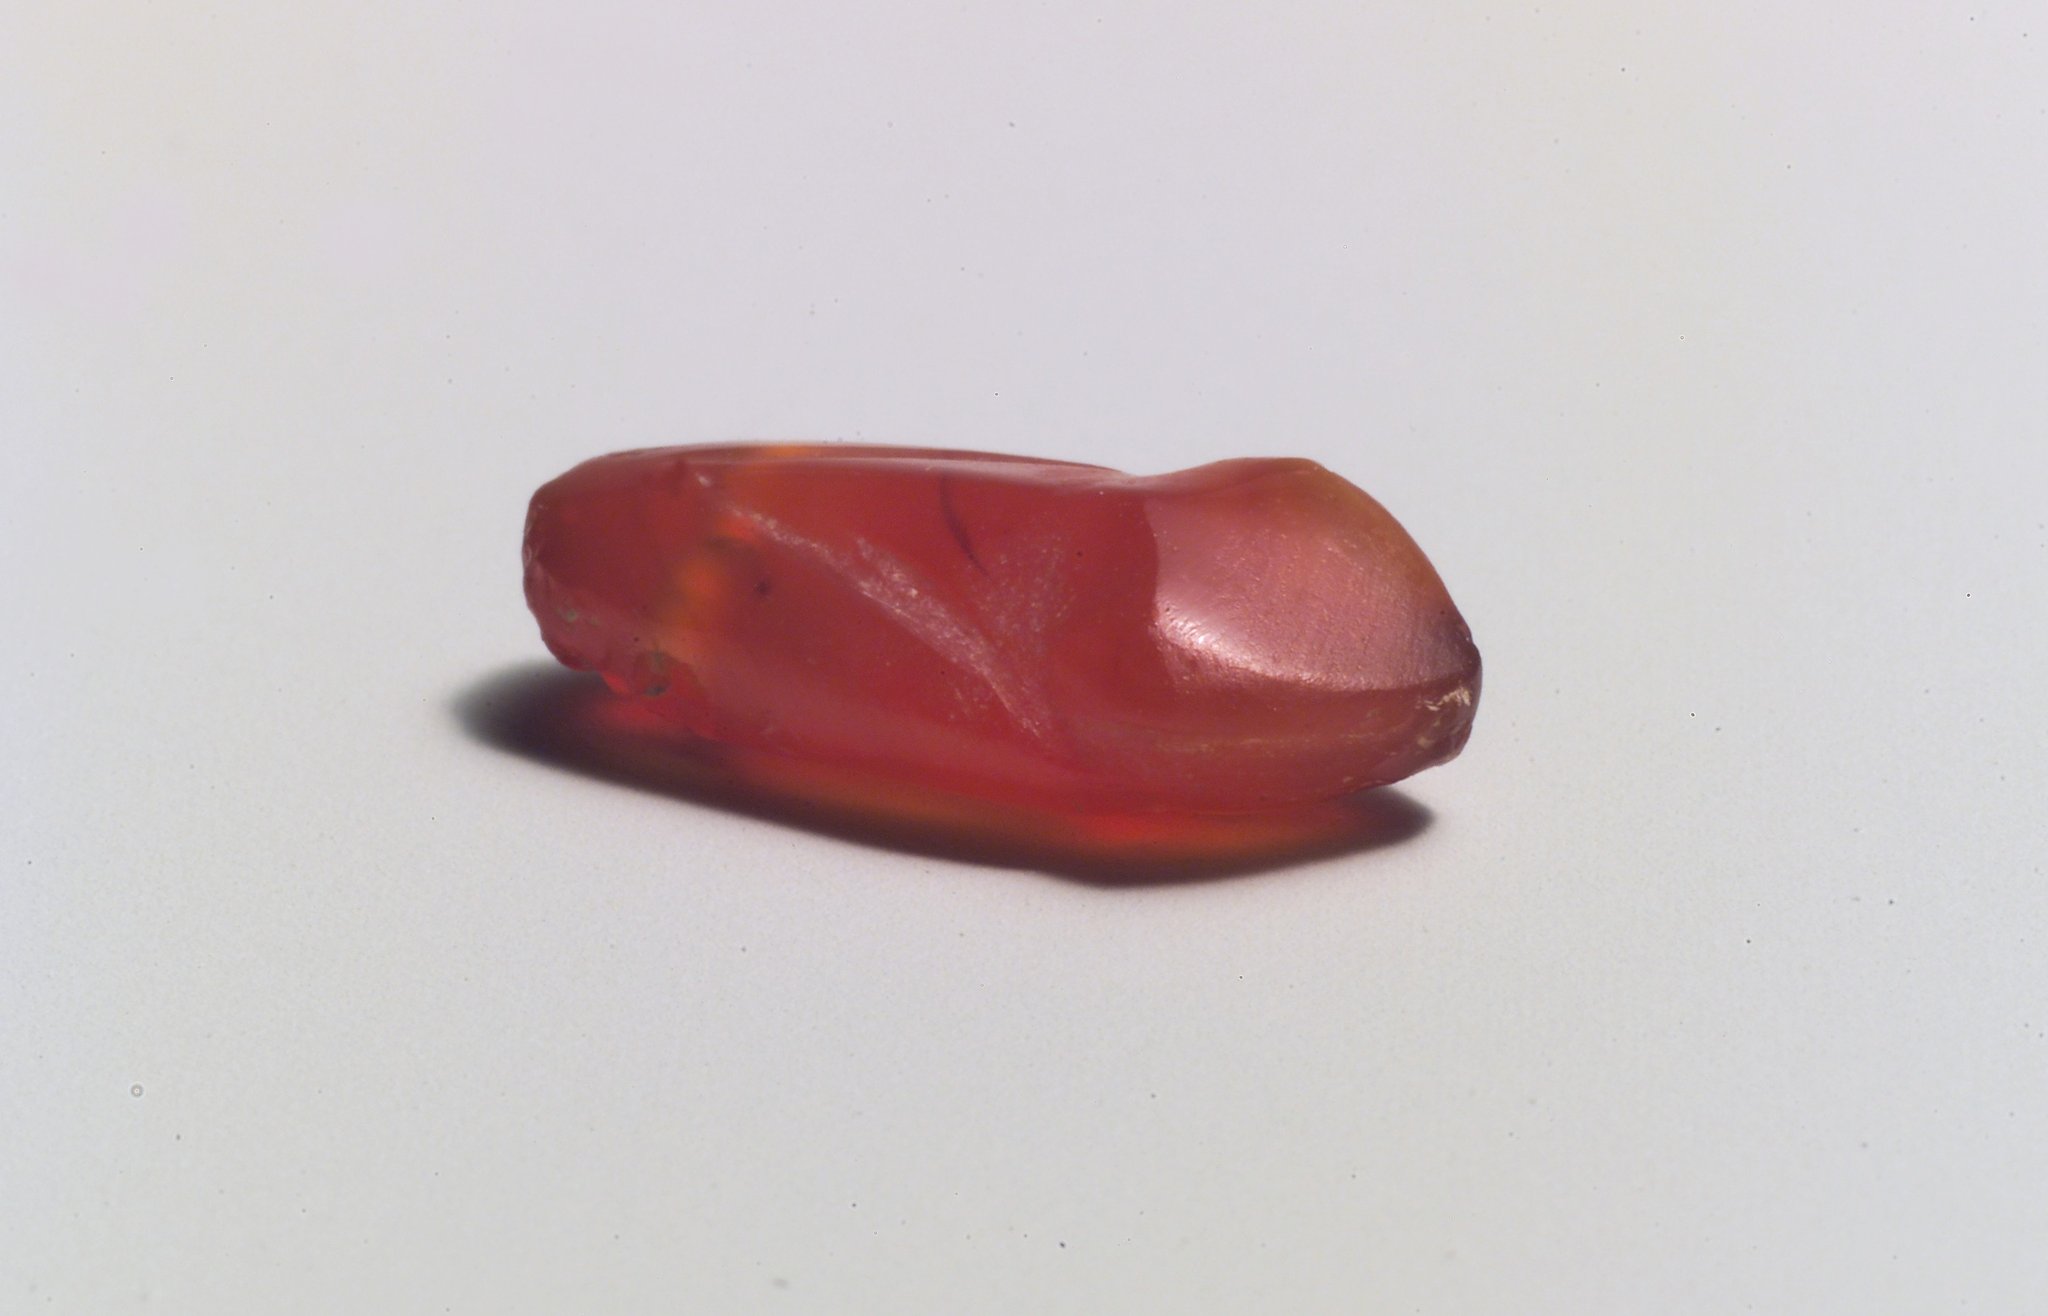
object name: amulet, snake head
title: Snake-head Amulet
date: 1981-1640 BCE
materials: gemstone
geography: egypt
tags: snakes